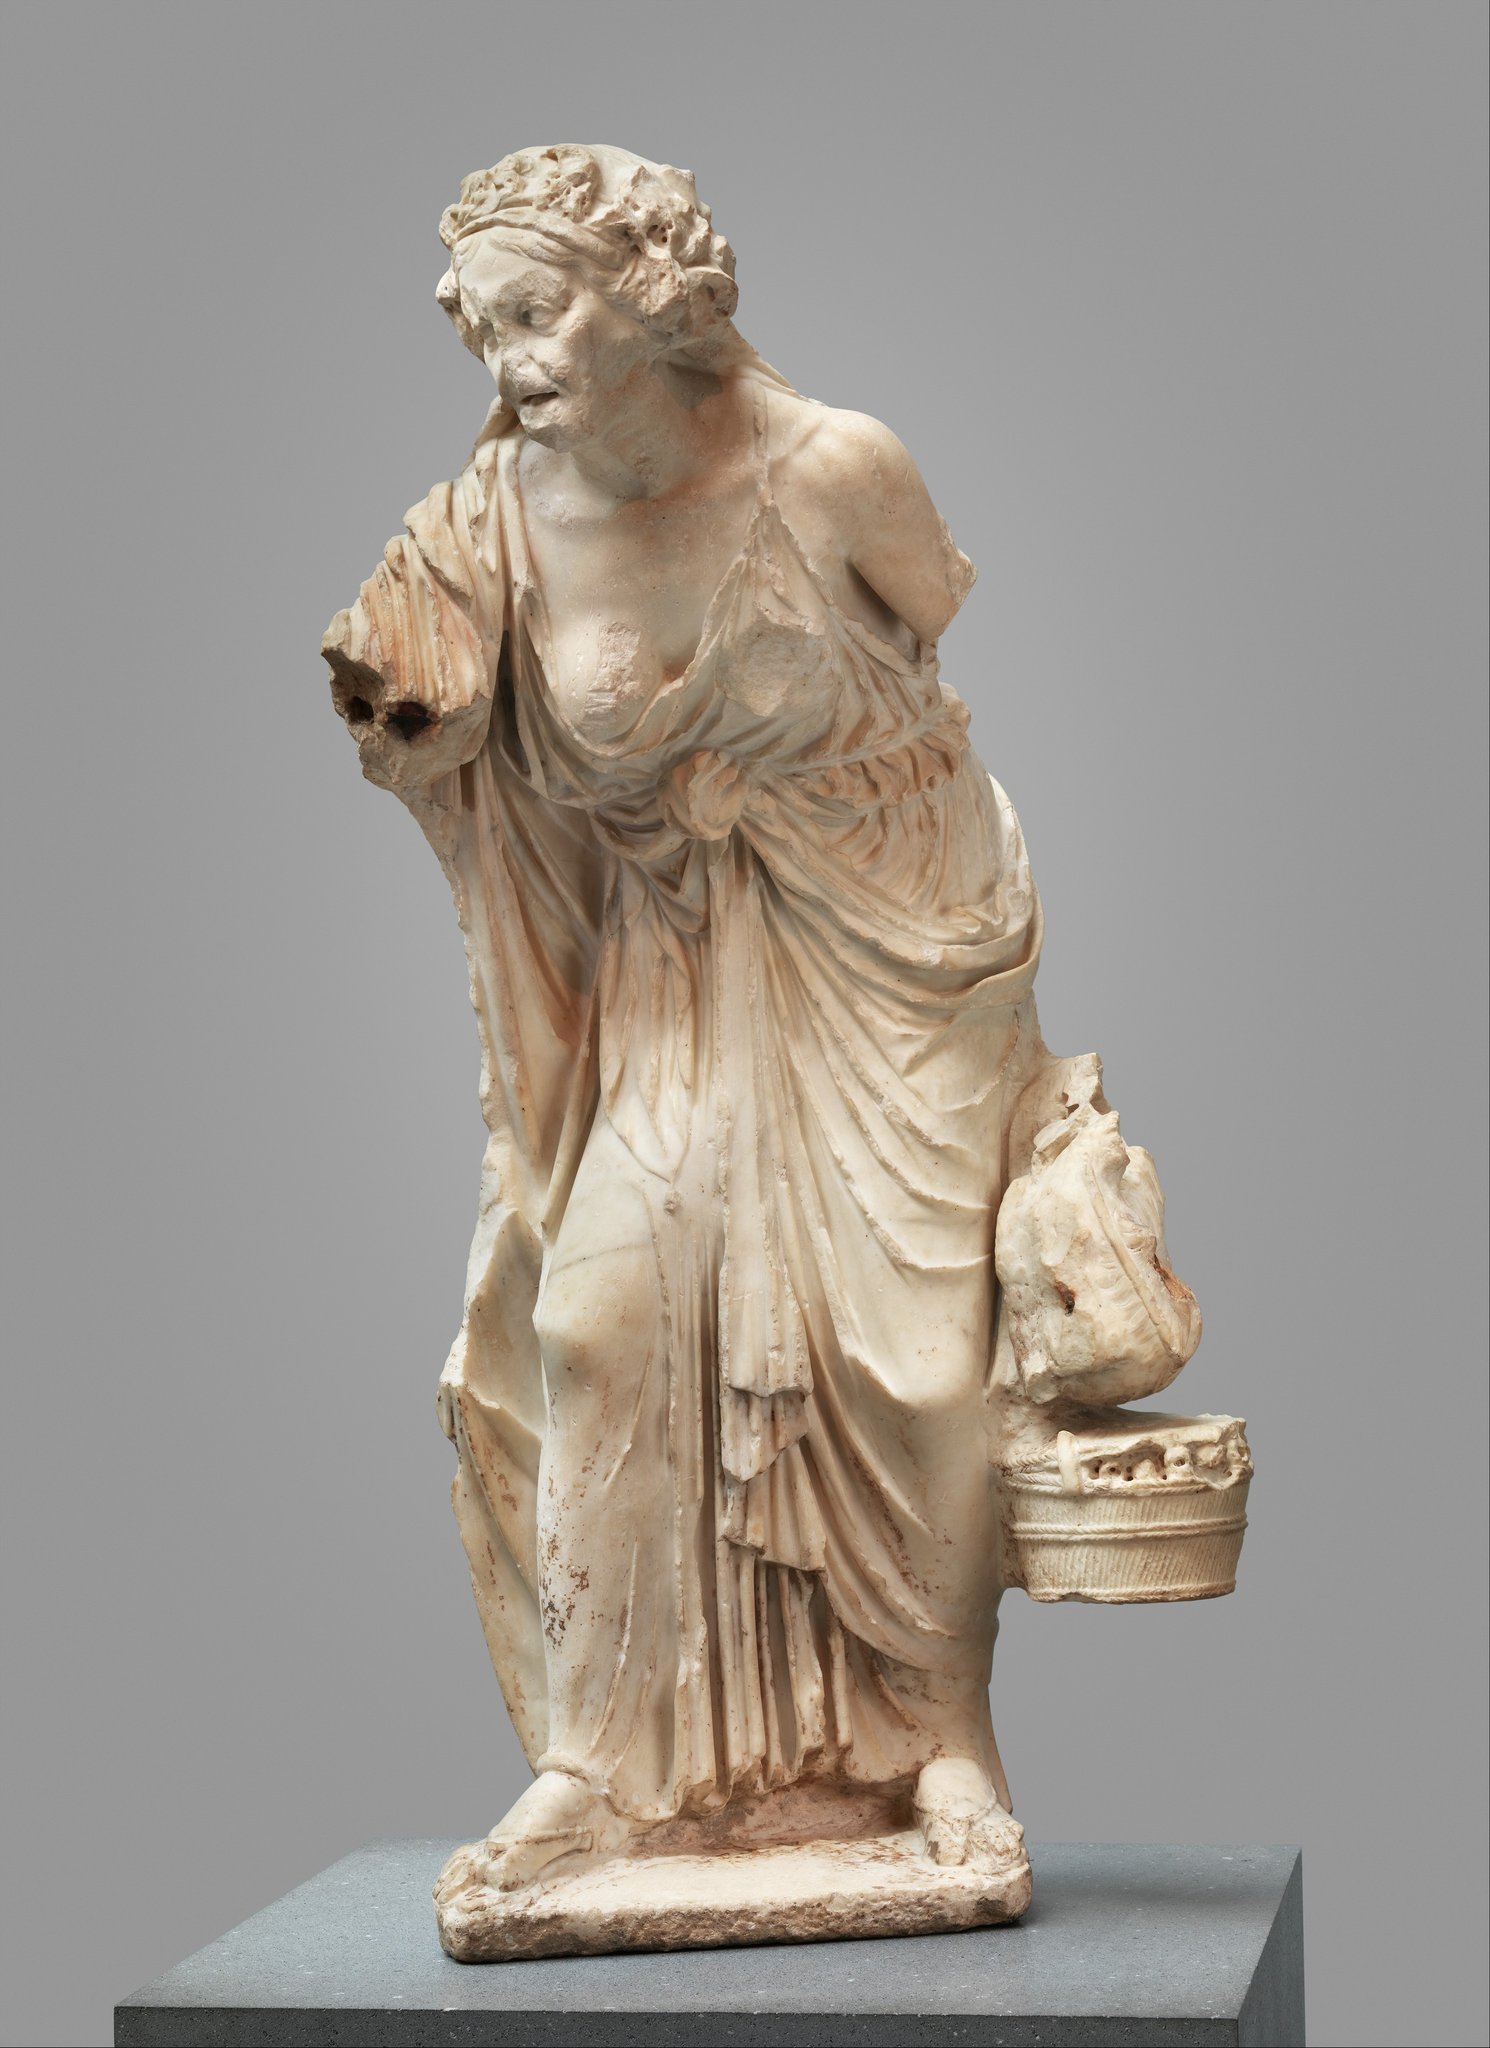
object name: statue of an old market woman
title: Marble statue of an old woman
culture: roman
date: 14-68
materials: marble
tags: women